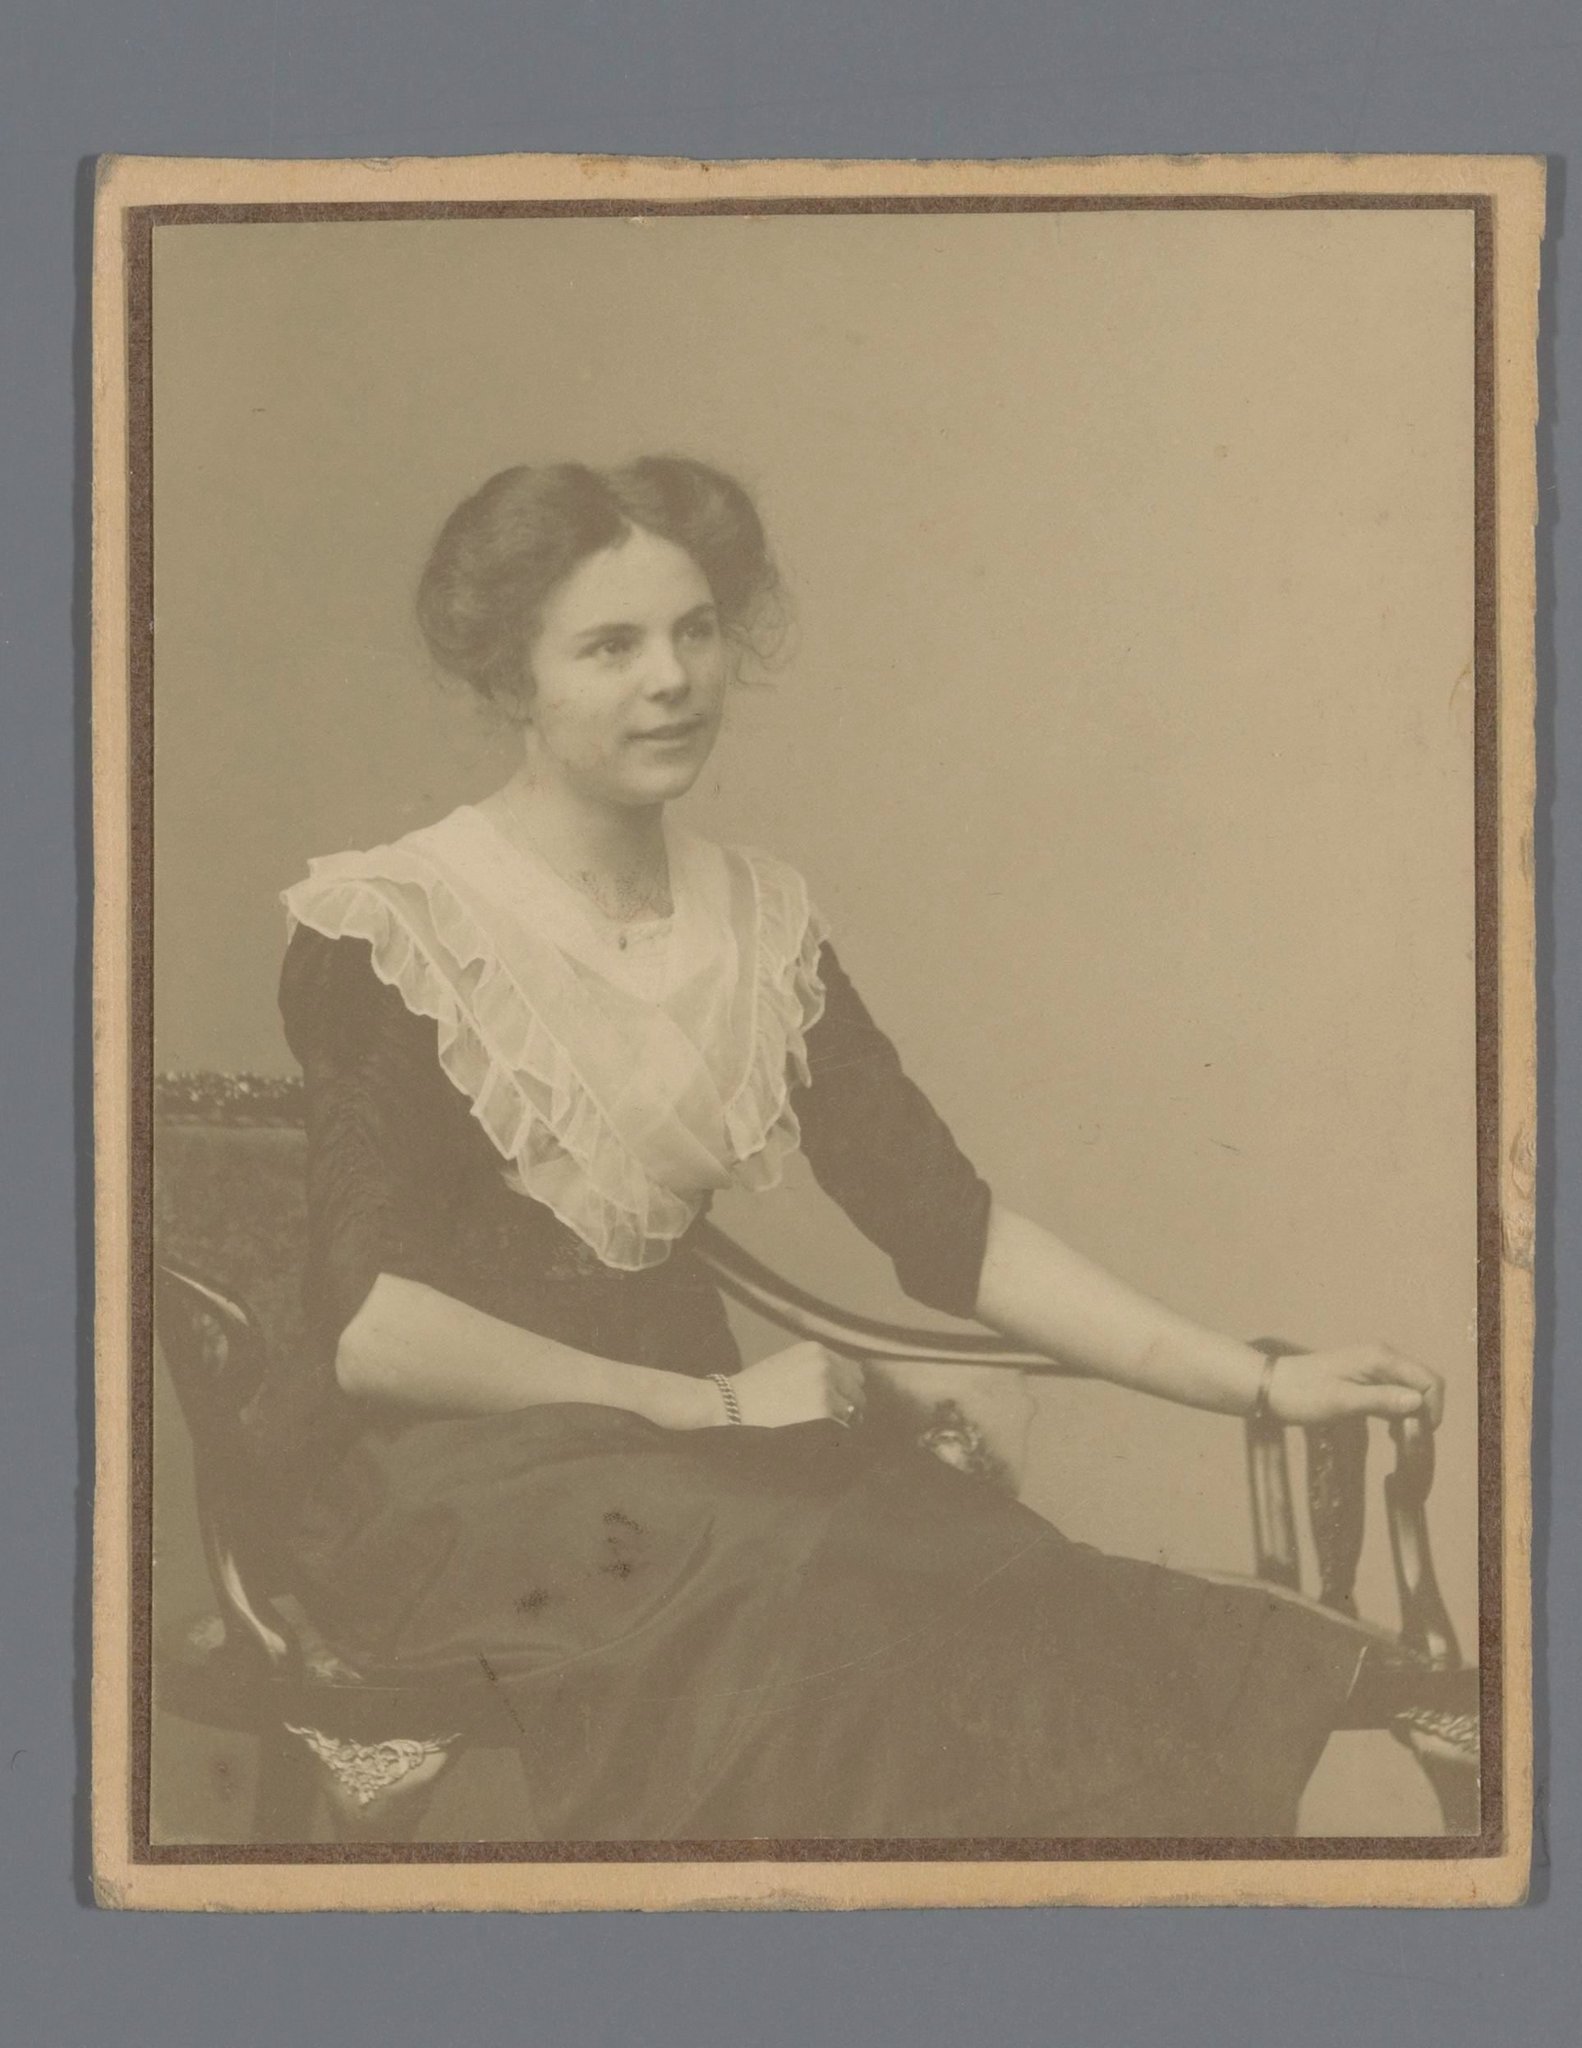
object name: photograph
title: Portret van een onbekende vrouw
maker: Anonymous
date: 1910-1925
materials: photographic support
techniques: gelatin silver print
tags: adult woman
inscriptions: inscription: ‘Wil’